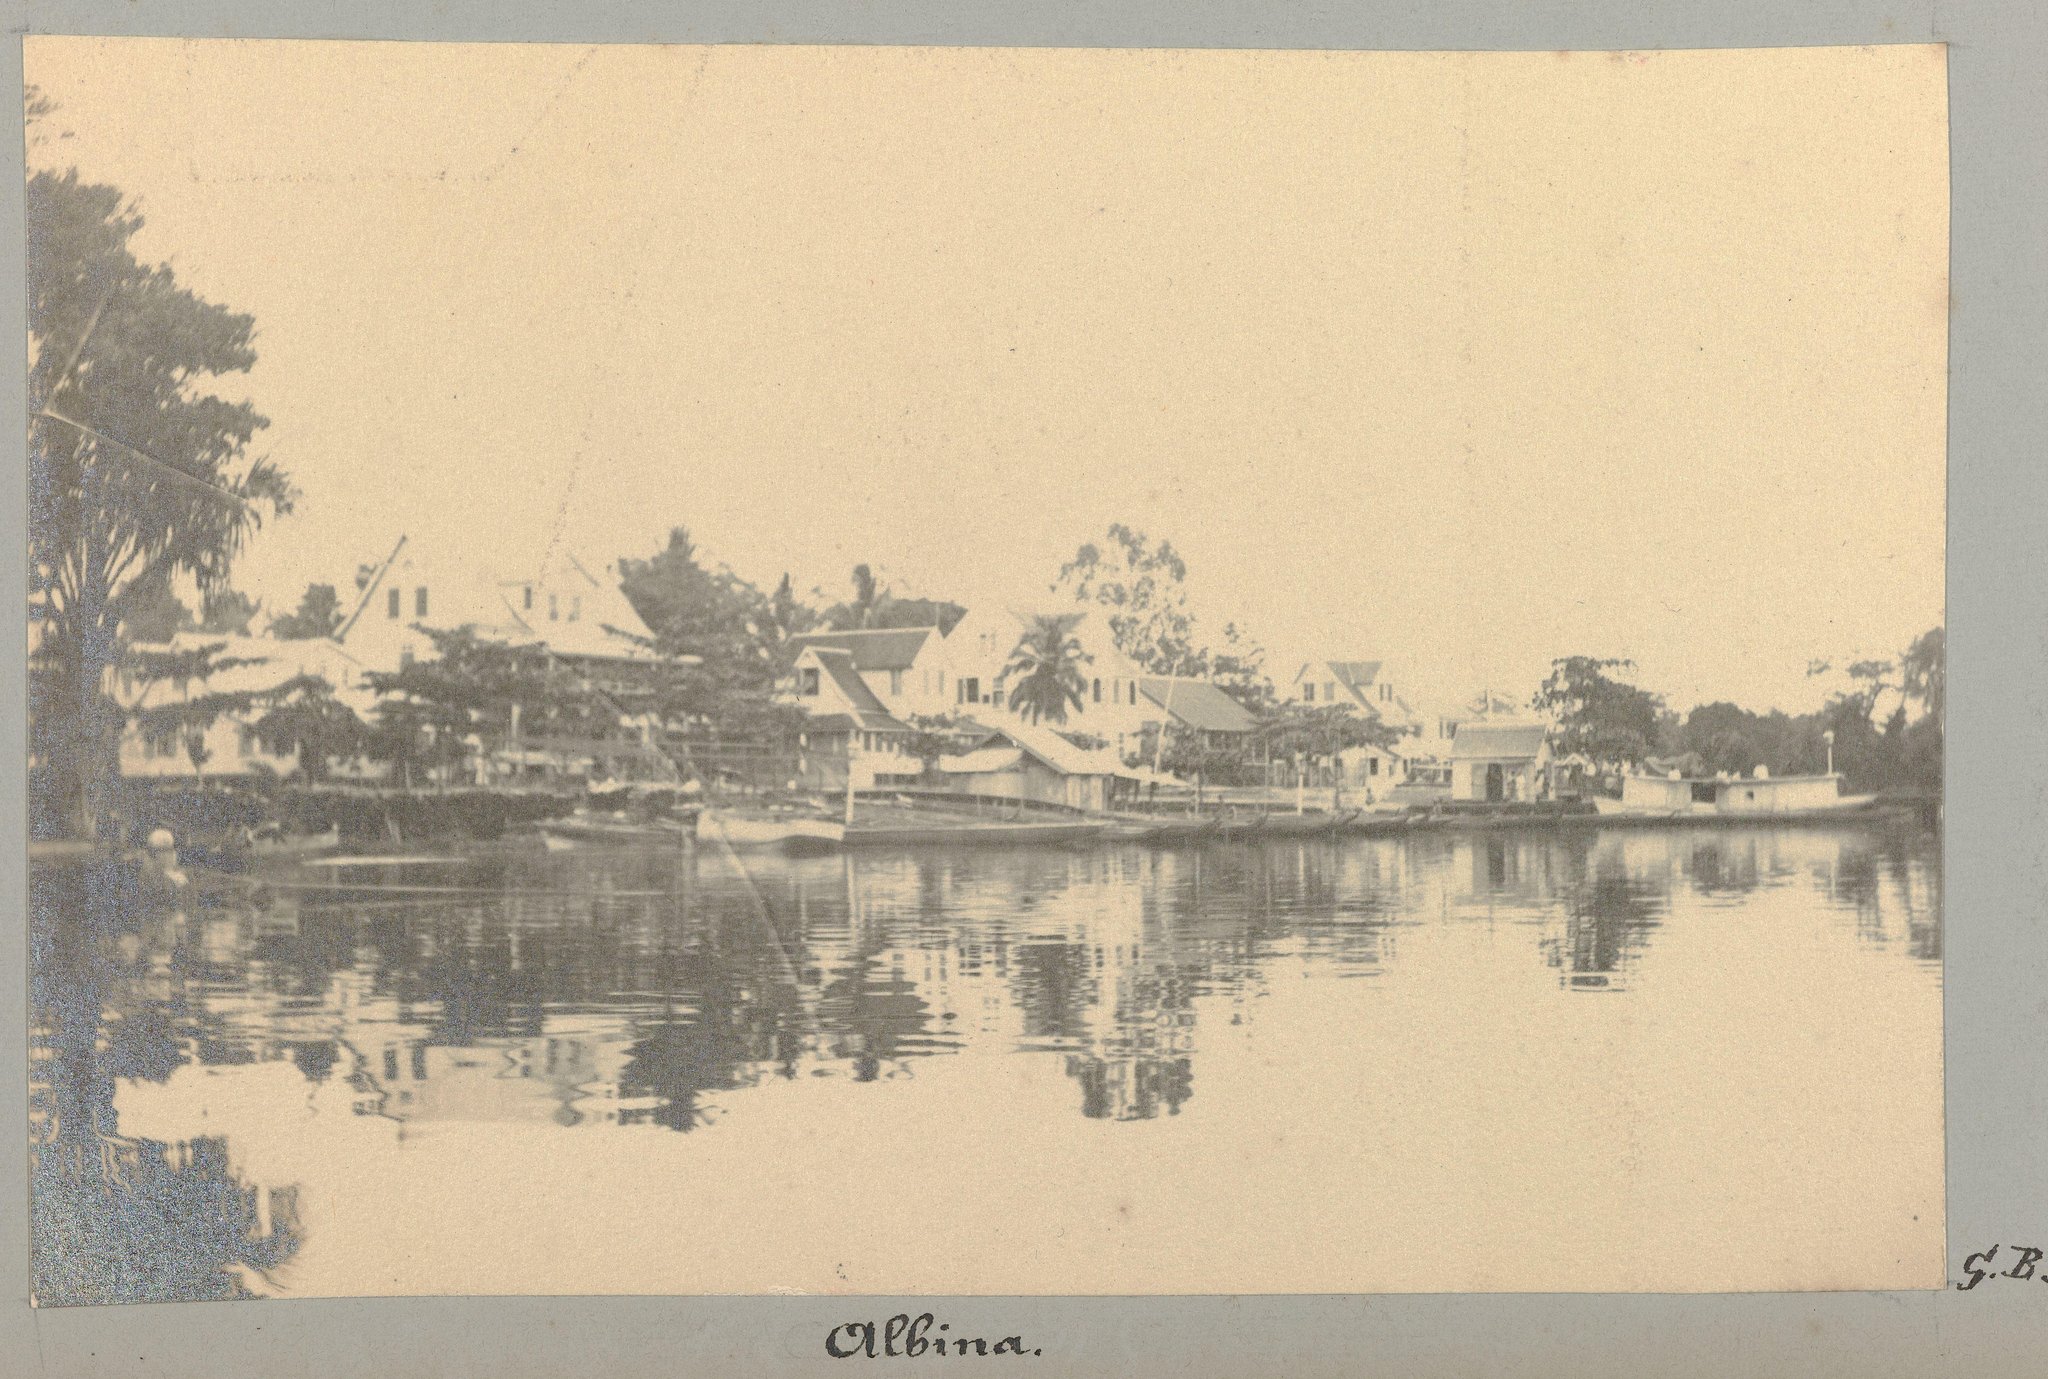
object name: photograph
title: Albina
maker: gomez burke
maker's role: fotograaf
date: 1891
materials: photographic support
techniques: gelatin silver print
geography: suriname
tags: suriname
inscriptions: inscription: ‘G.B. / Albina.’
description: Gezicht op de Waterkant met huizen te Albina. Onderdeel van het fotoalbum Souvenir de Voyage (deel 4), over het leven van de familie Dooyer in en rond de plantage Ma Retraite in Suriname in de jaren 1906-1913.